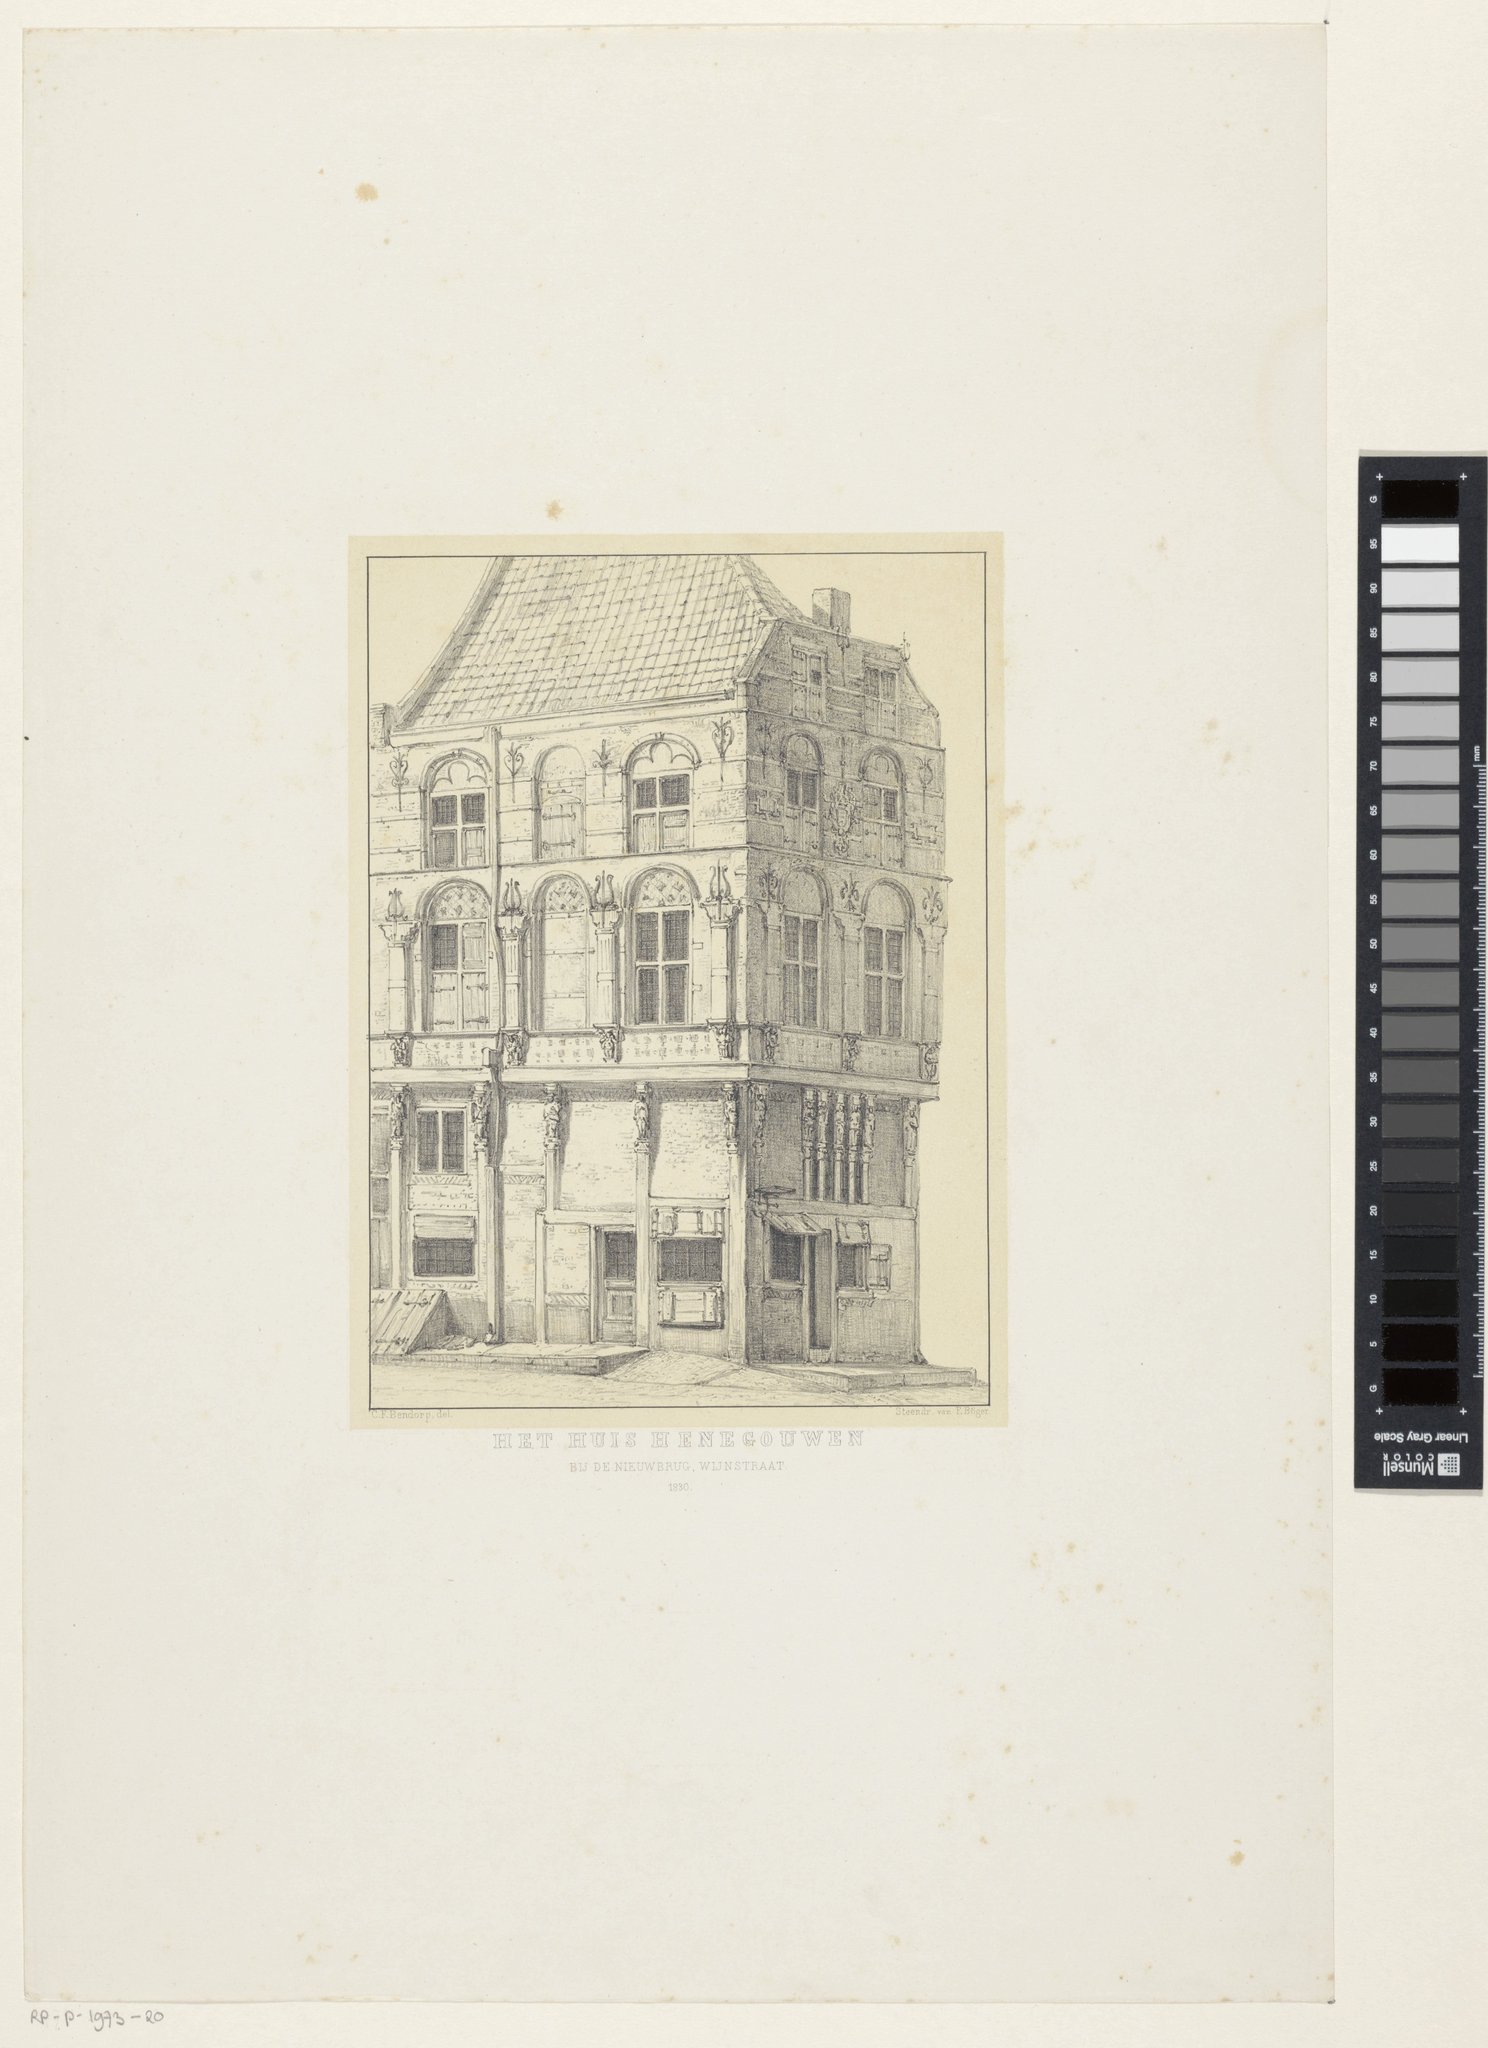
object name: print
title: Huis Henegouwen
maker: carel frederik bendorp (ii)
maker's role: draughtsman, painter, print maker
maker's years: 1819-1897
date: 1872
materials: paper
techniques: tone lithography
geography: dordrecht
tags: column, pillar ~ architecture, façade (of house or building), dordrecht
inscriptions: collector's mark: Lugt 2760, collector's mark: Lugt 2228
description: De gevel van het huis is gedecoreerd met sculpturen, pilasters en glas in lood. Onder de naam van het huis staat vermeld: bij de Nieuwbrug, Wijnstraat. Daaronder het jaartal 1830.